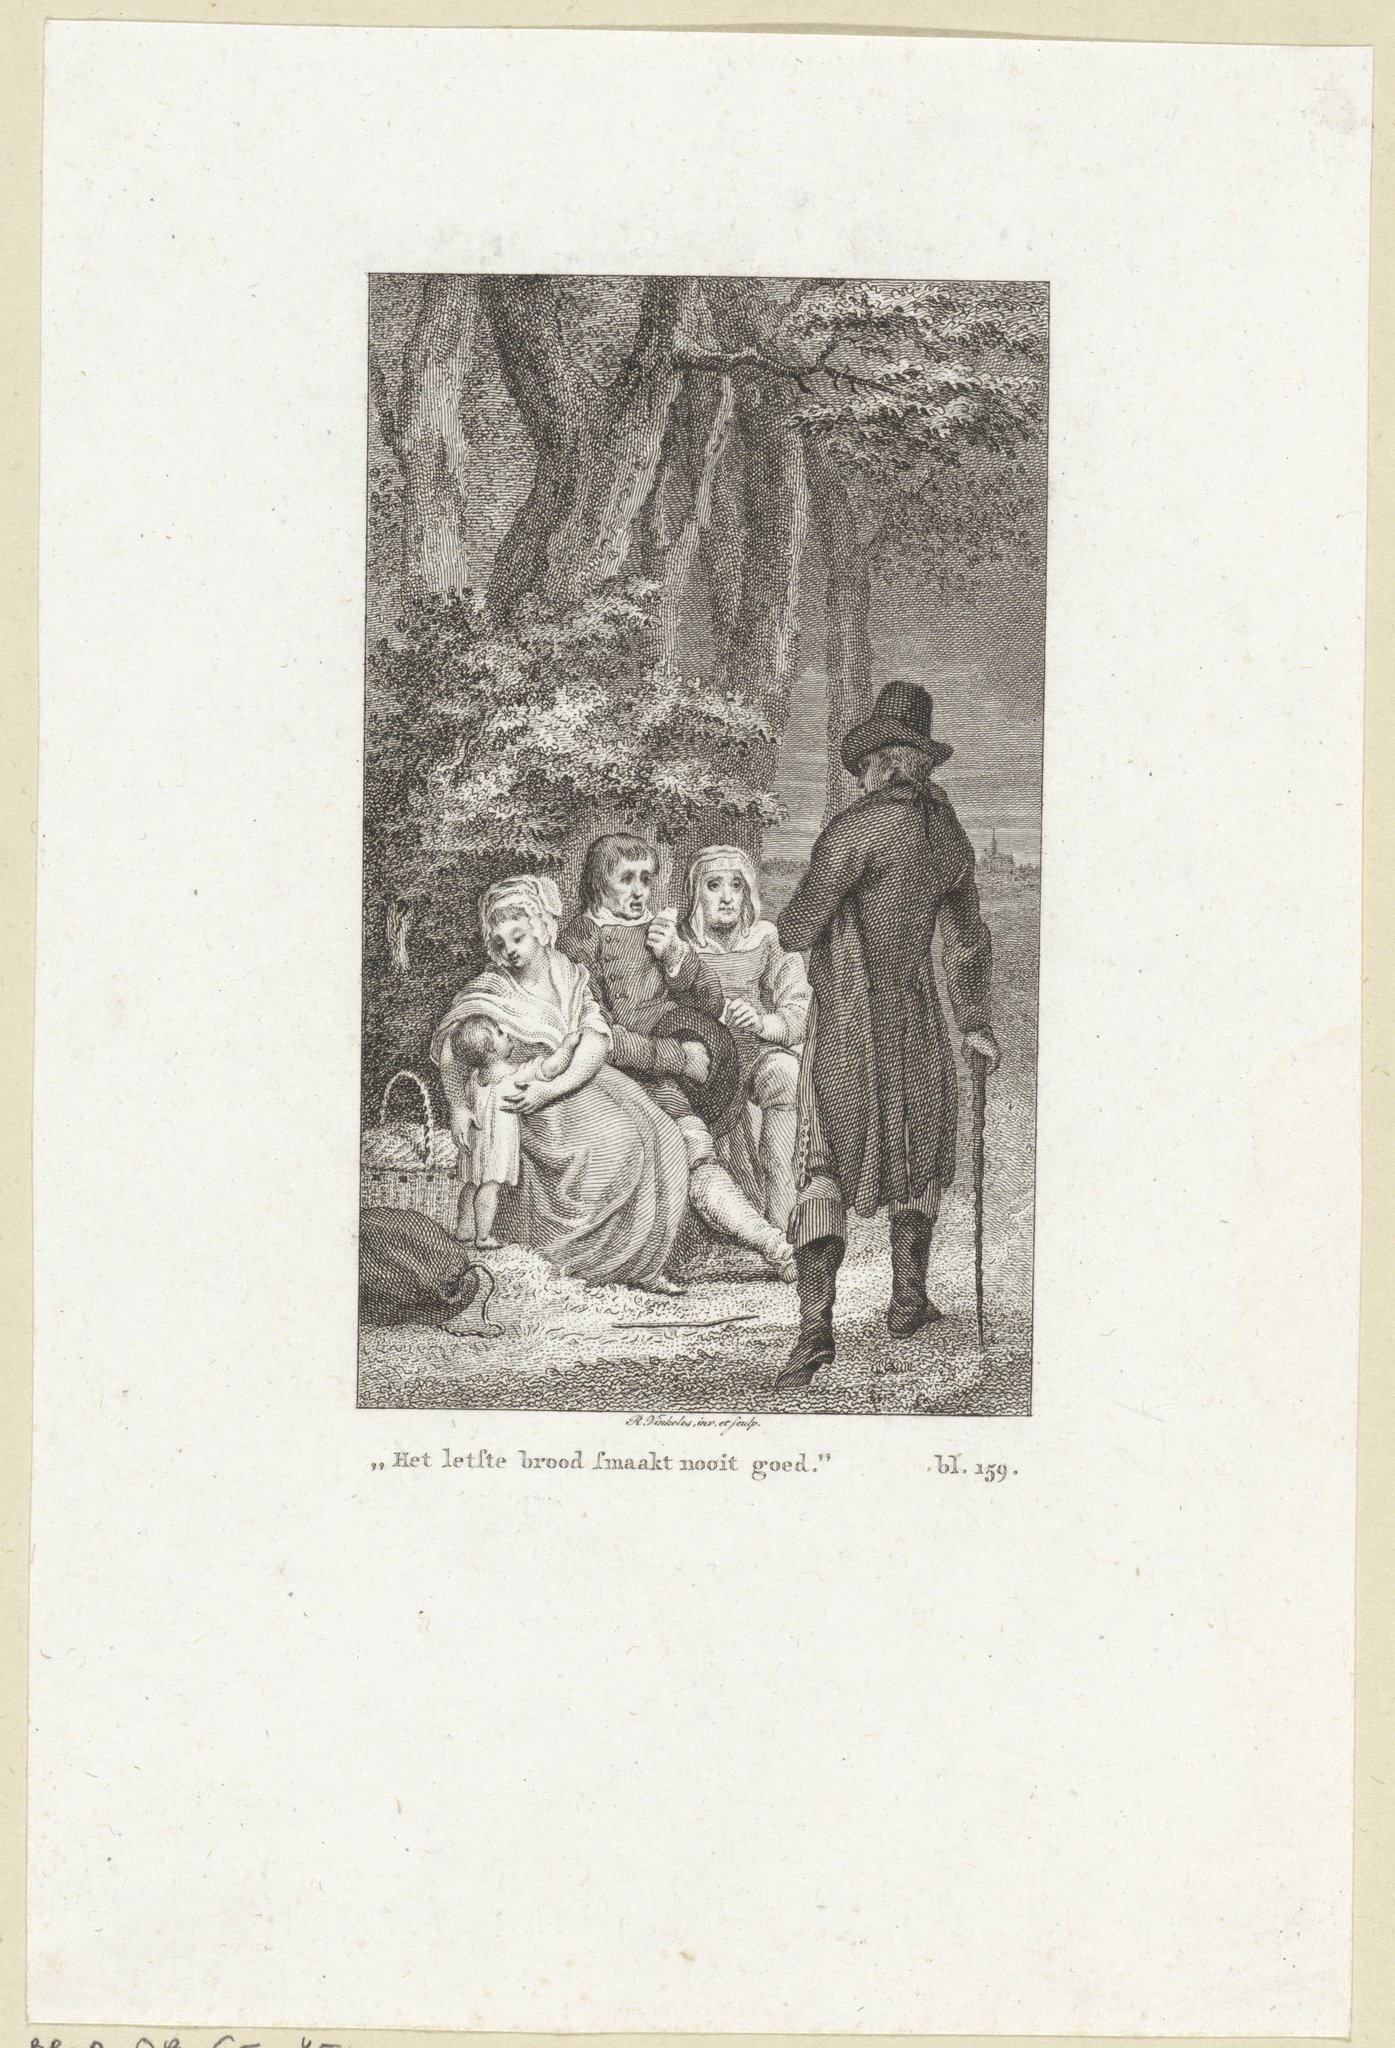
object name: print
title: Bosgezicht met lieden die een gesprek voeren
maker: reinier vinkeles (i)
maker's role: draughtsman, print maker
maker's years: 1741-1816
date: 1751-1816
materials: paper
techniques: engraving, etching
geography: amsterdam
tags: bread, loaf, forest, wood, conversation, dialogue; conversation piece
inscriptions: collector's mark: Lugt 240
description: Aan de rand van een bos eten een man en twee vrouwen, waarvan een met een jong kind, hun laatste brood. Een voorbijganger knoopt een gesprek met hen aan.